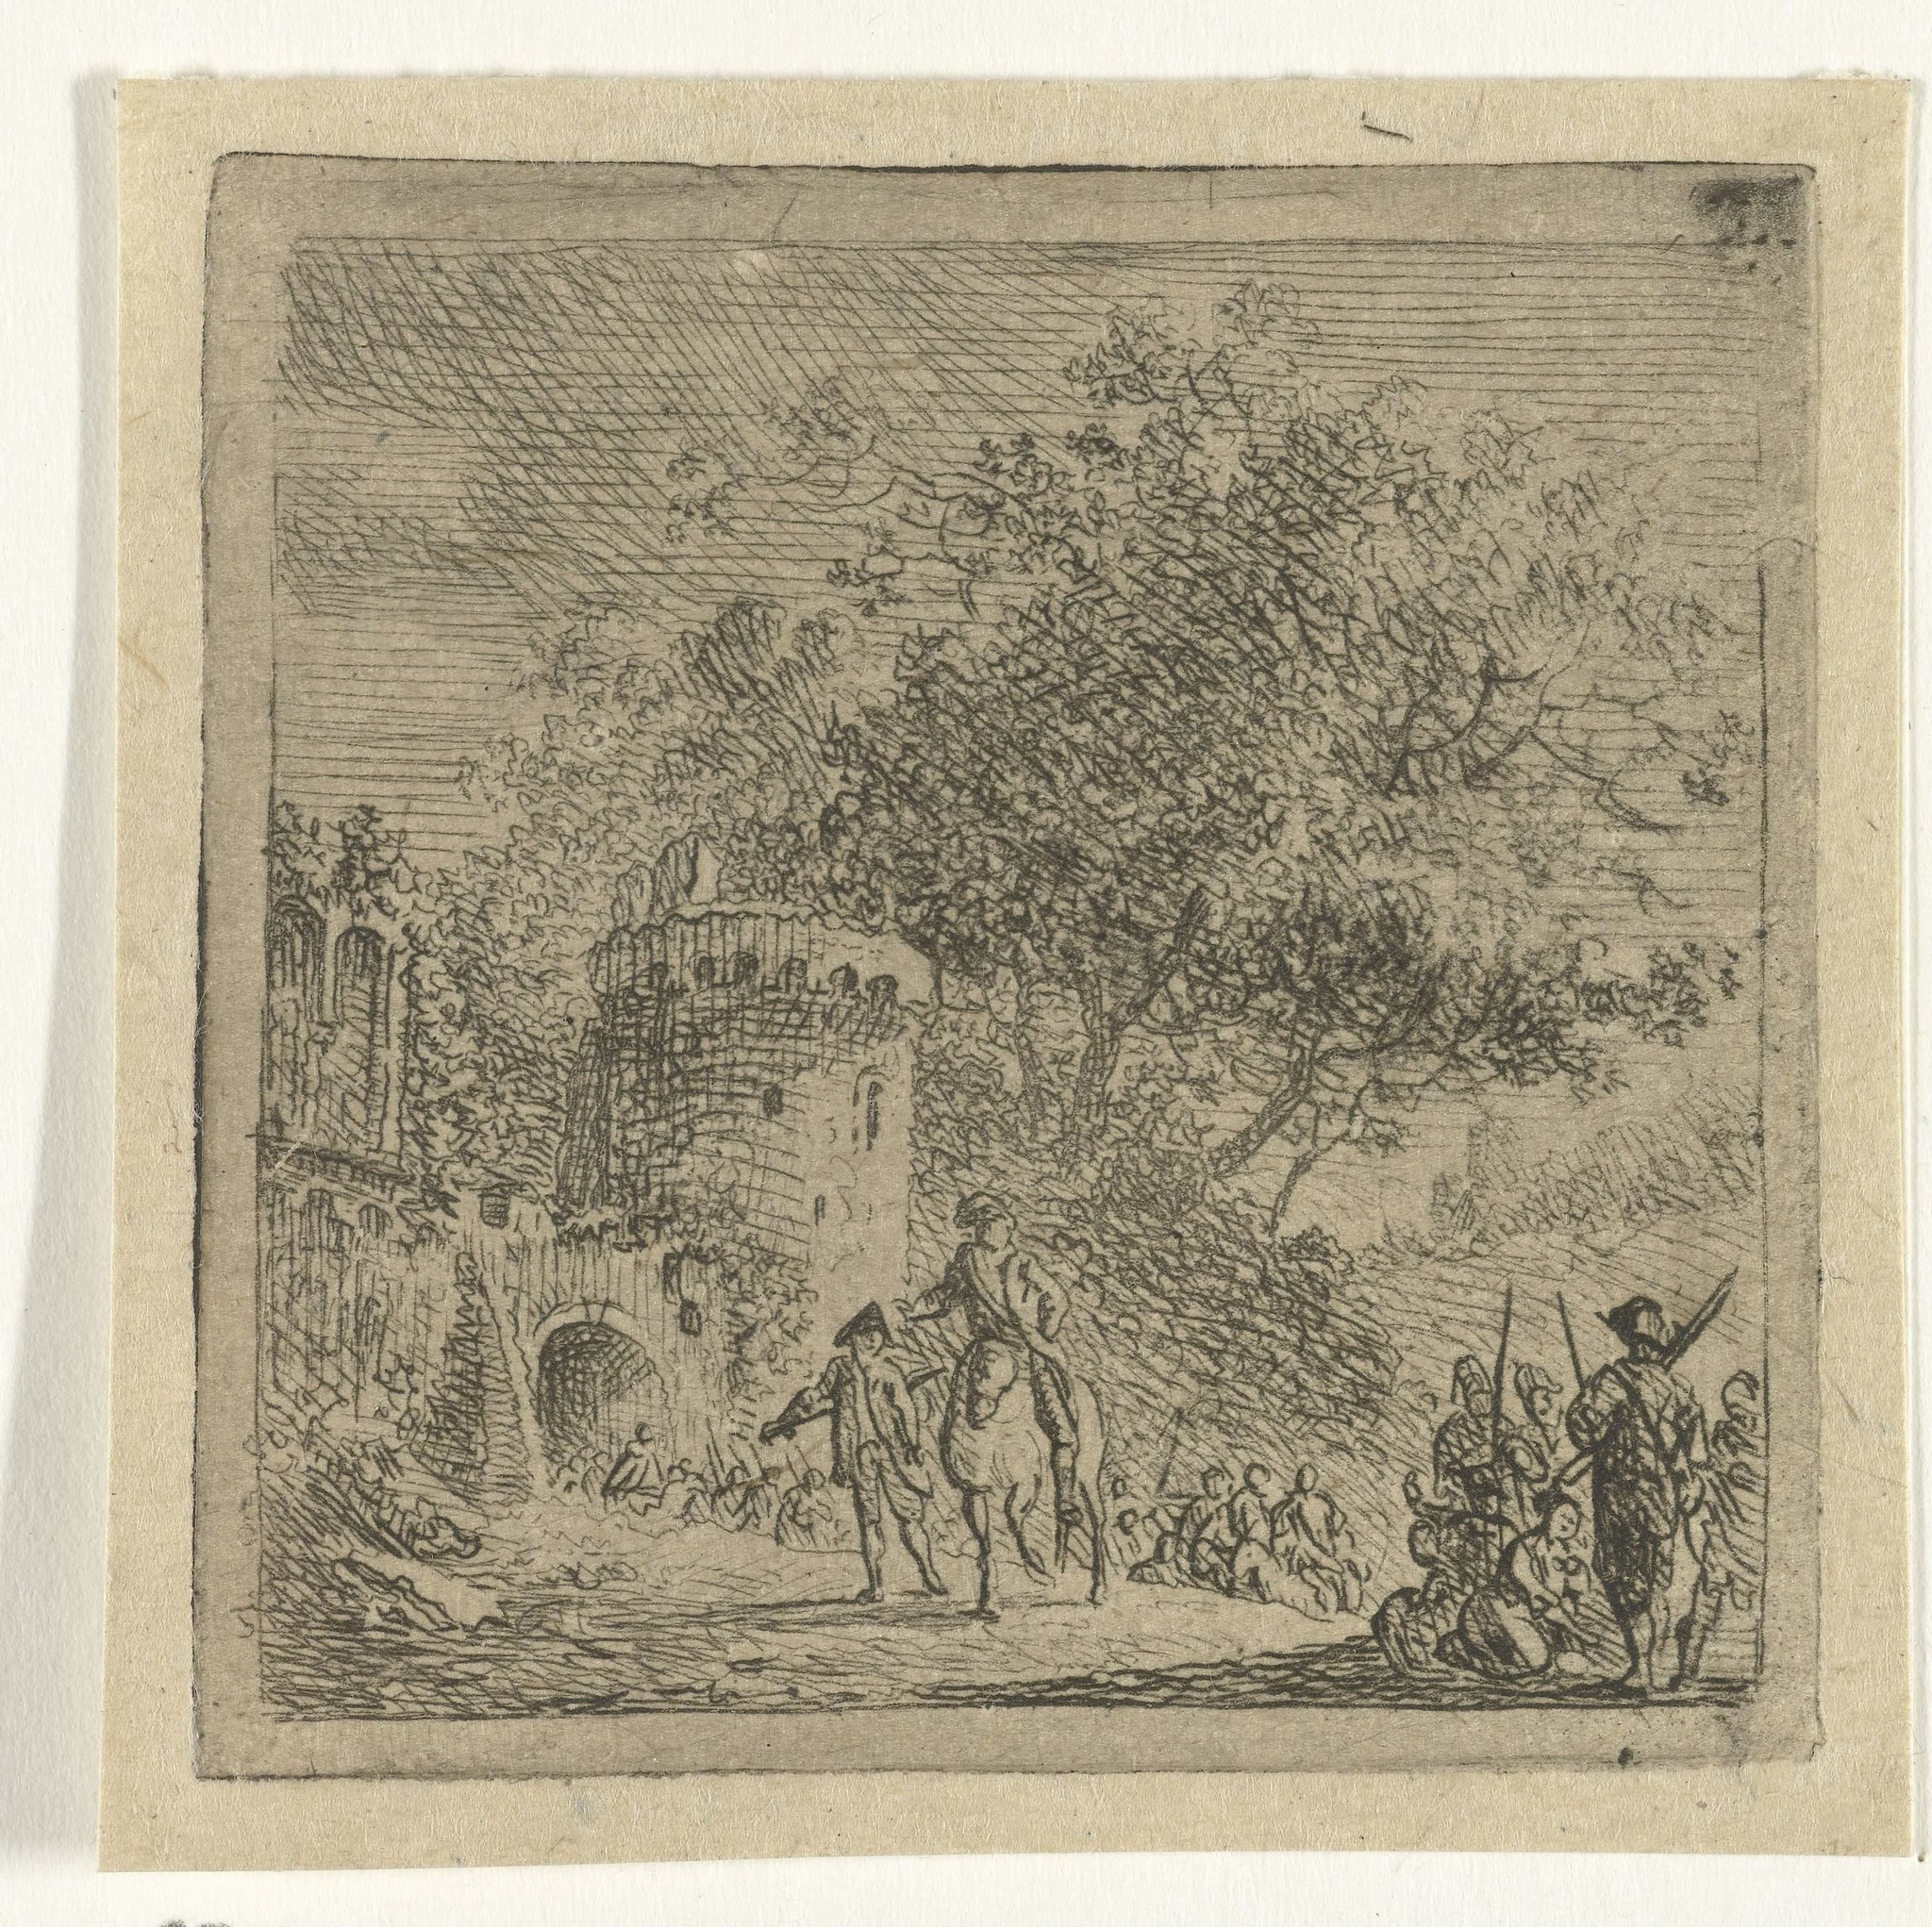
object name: print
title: Soldaten bij een poort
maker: cornelis van hardenbergh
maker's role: draughtsman, painter, print maker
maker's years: 1755-1843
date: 1770-1843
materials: paper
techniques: etching, intaglio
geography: netherlands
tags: the soldier; the soldier's life, city-gate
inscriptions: collector's mark: Lugt 2228